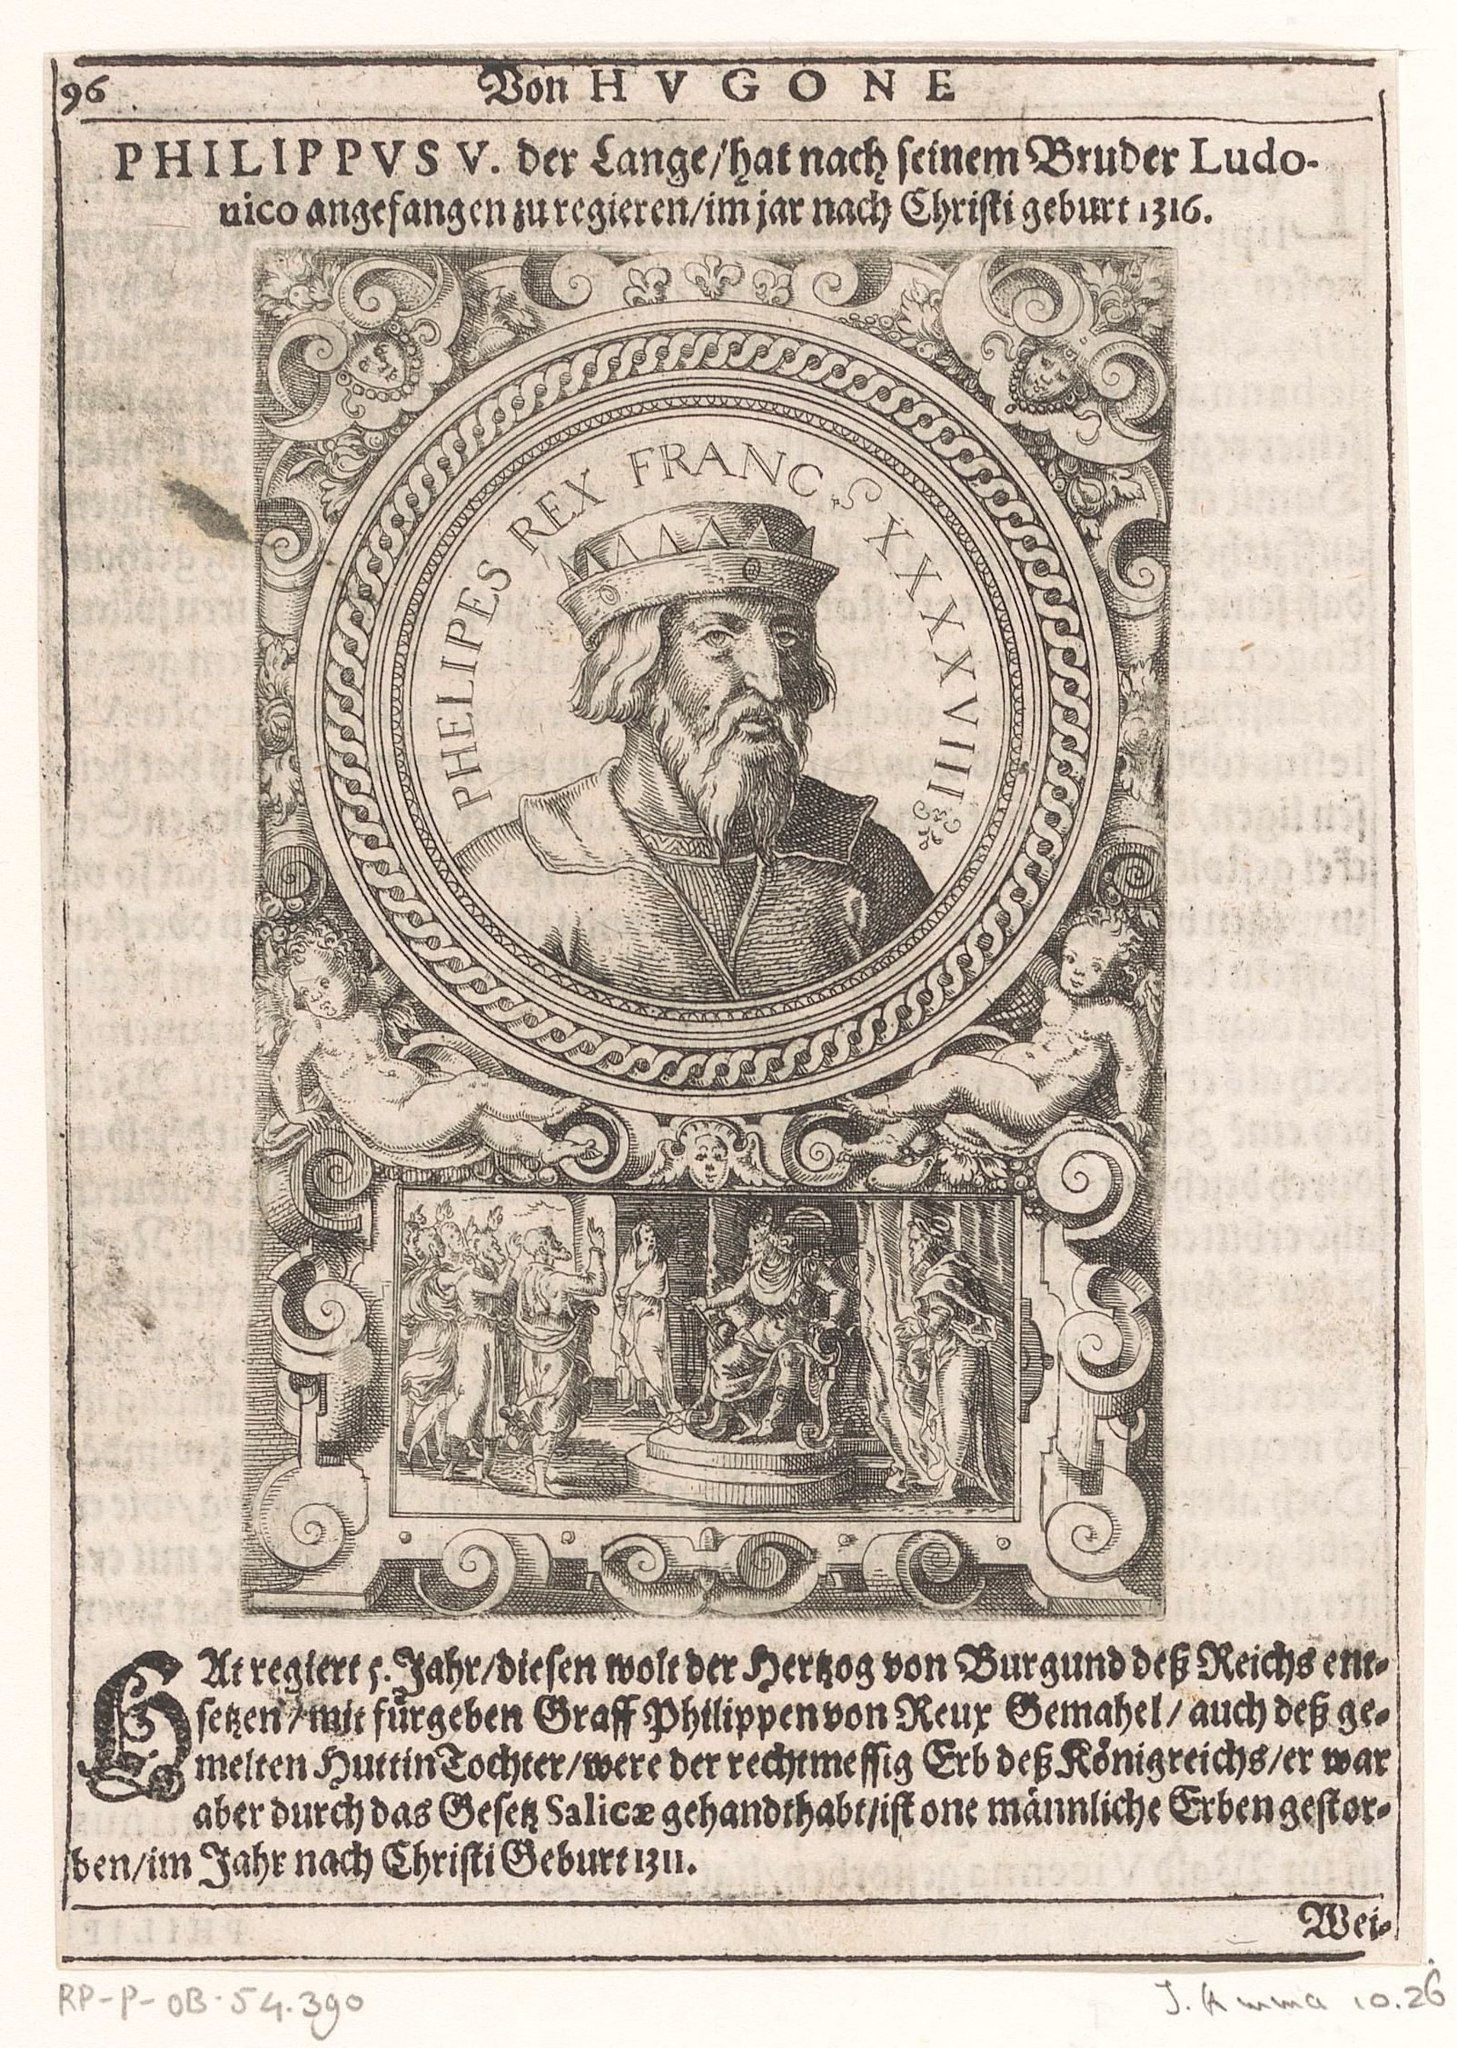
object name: print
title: Portret van Filips V, koning van Frankrijk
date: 1598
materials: paper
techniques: etching, intaglio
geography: nuremberg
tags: lyon, scrollwork, strapwork ~ ornament, historical persons, ruler, sovereign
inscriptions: number: ‘158’, collector's mark: Lugt 2228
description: Prent afkomstig uit de publicatie: Michael Eizinger. Könige in Frankreich. Keulen: Johann Bussemacher, 1598, p. 96. De publicatie bevat prenten van Jost Amman en Virgil Solis.